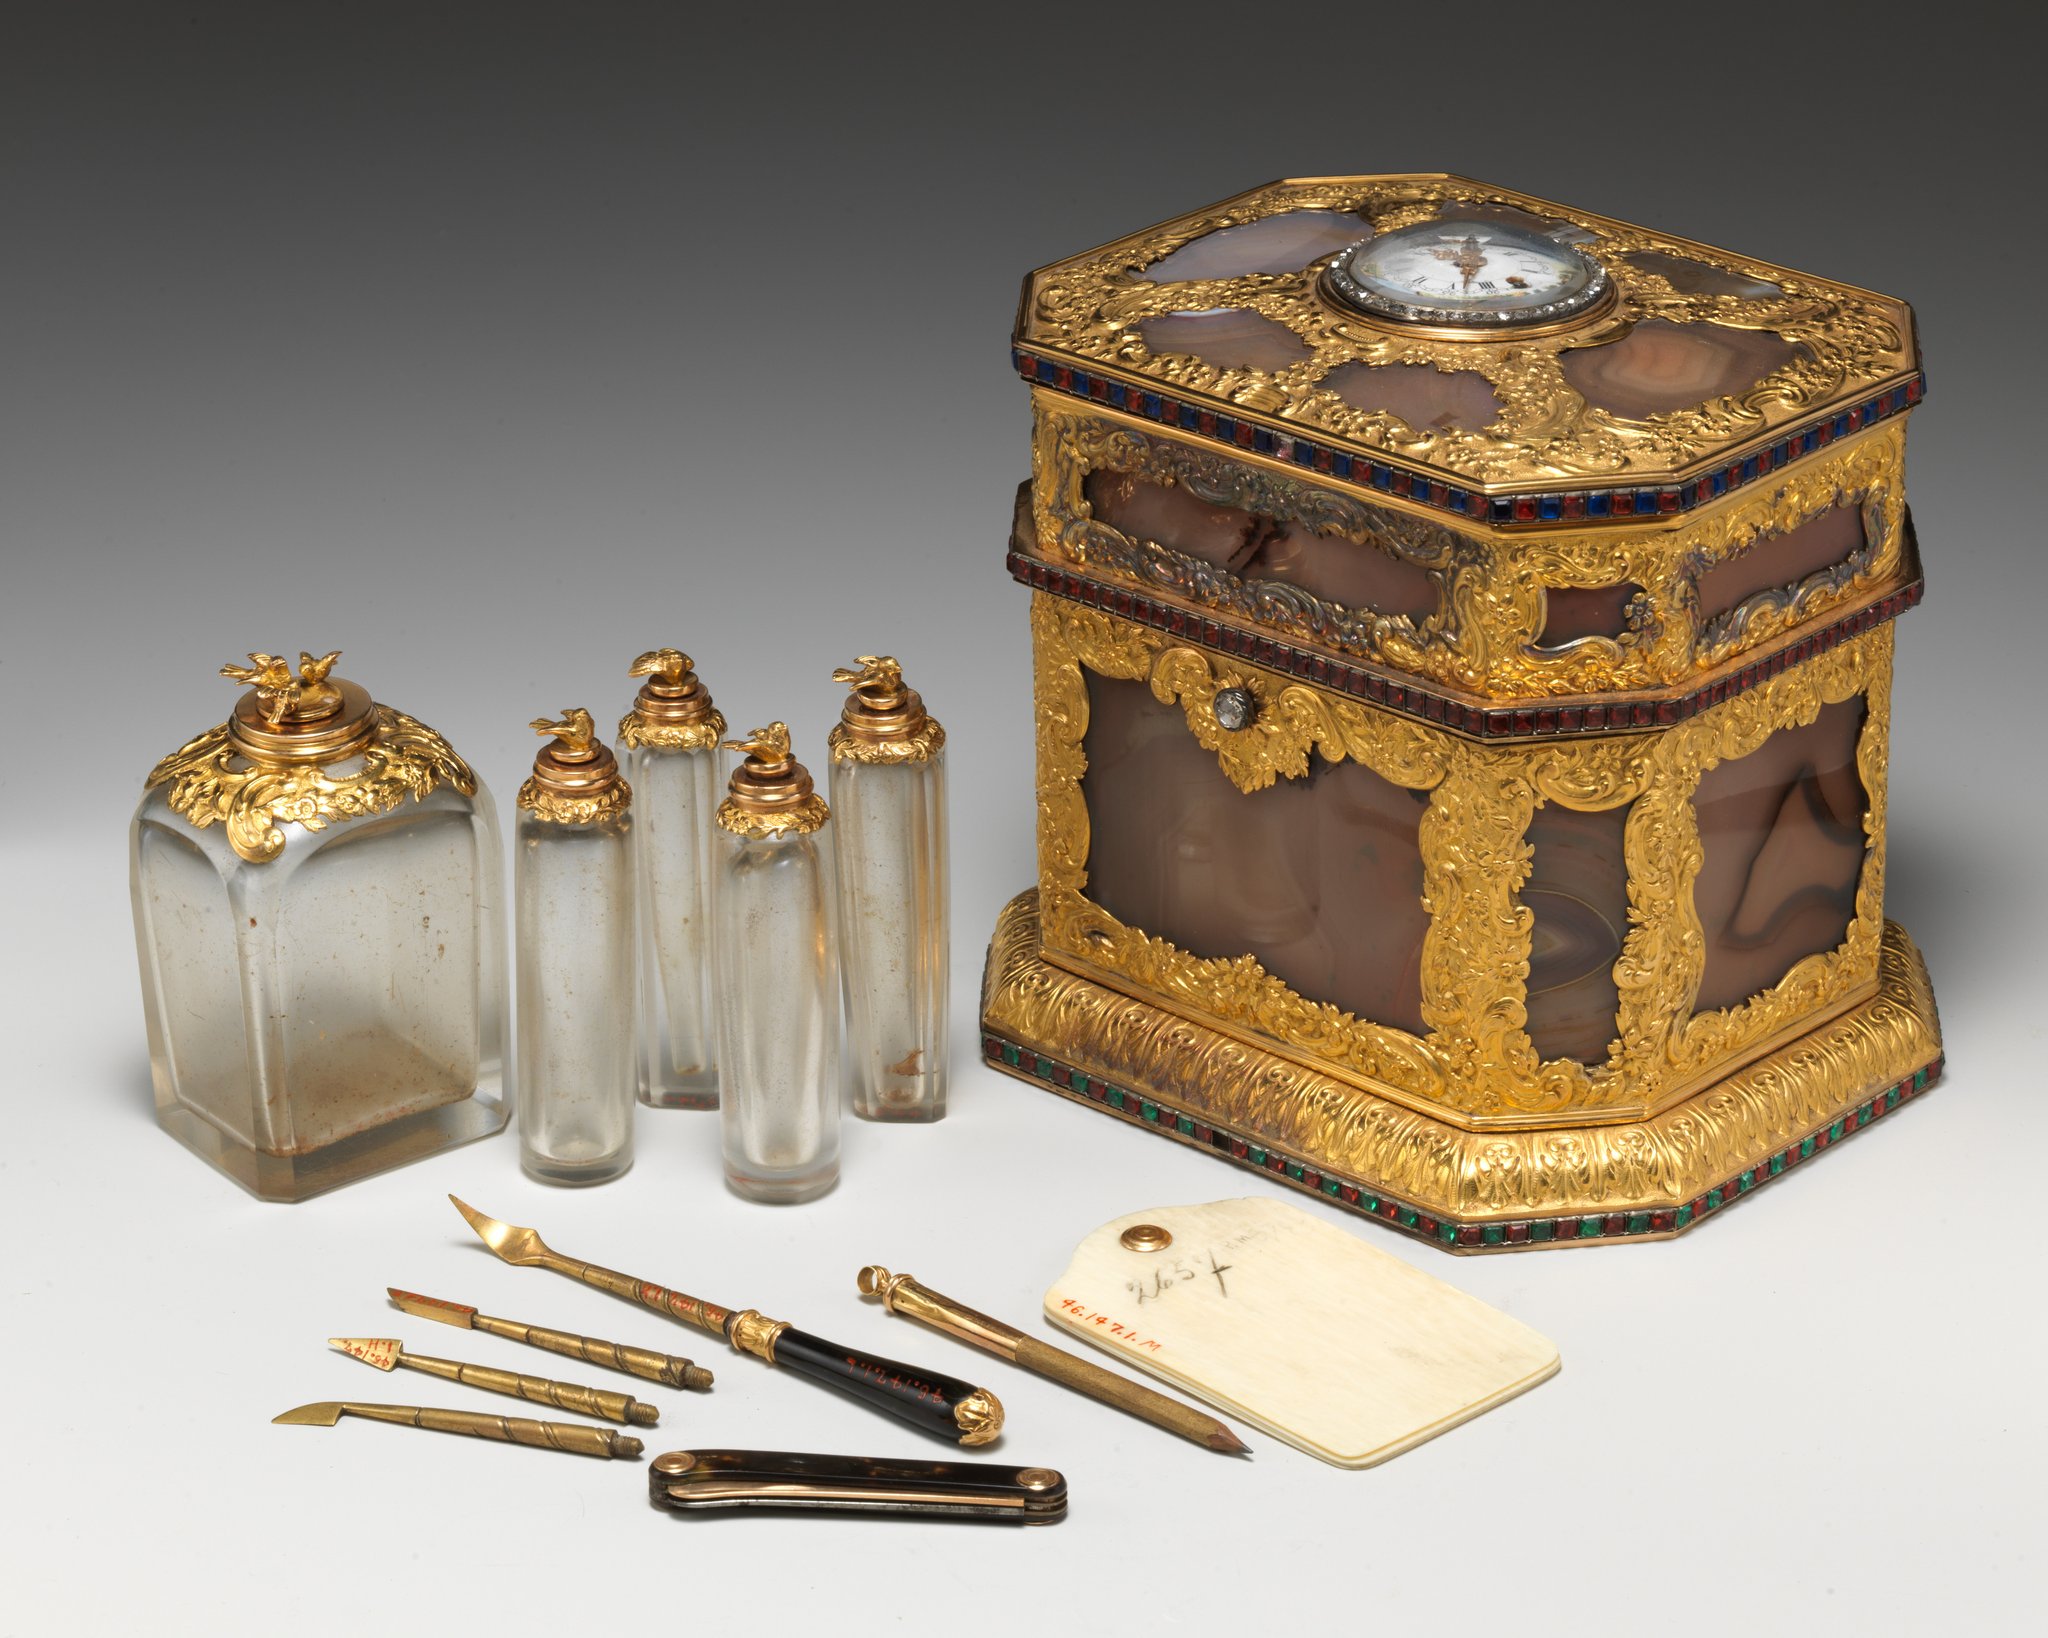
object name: nécessaire and watch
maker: j. orpion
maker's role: maker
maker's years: 1800-1900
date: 1801-1900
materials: stone, diamond, enamel, gold